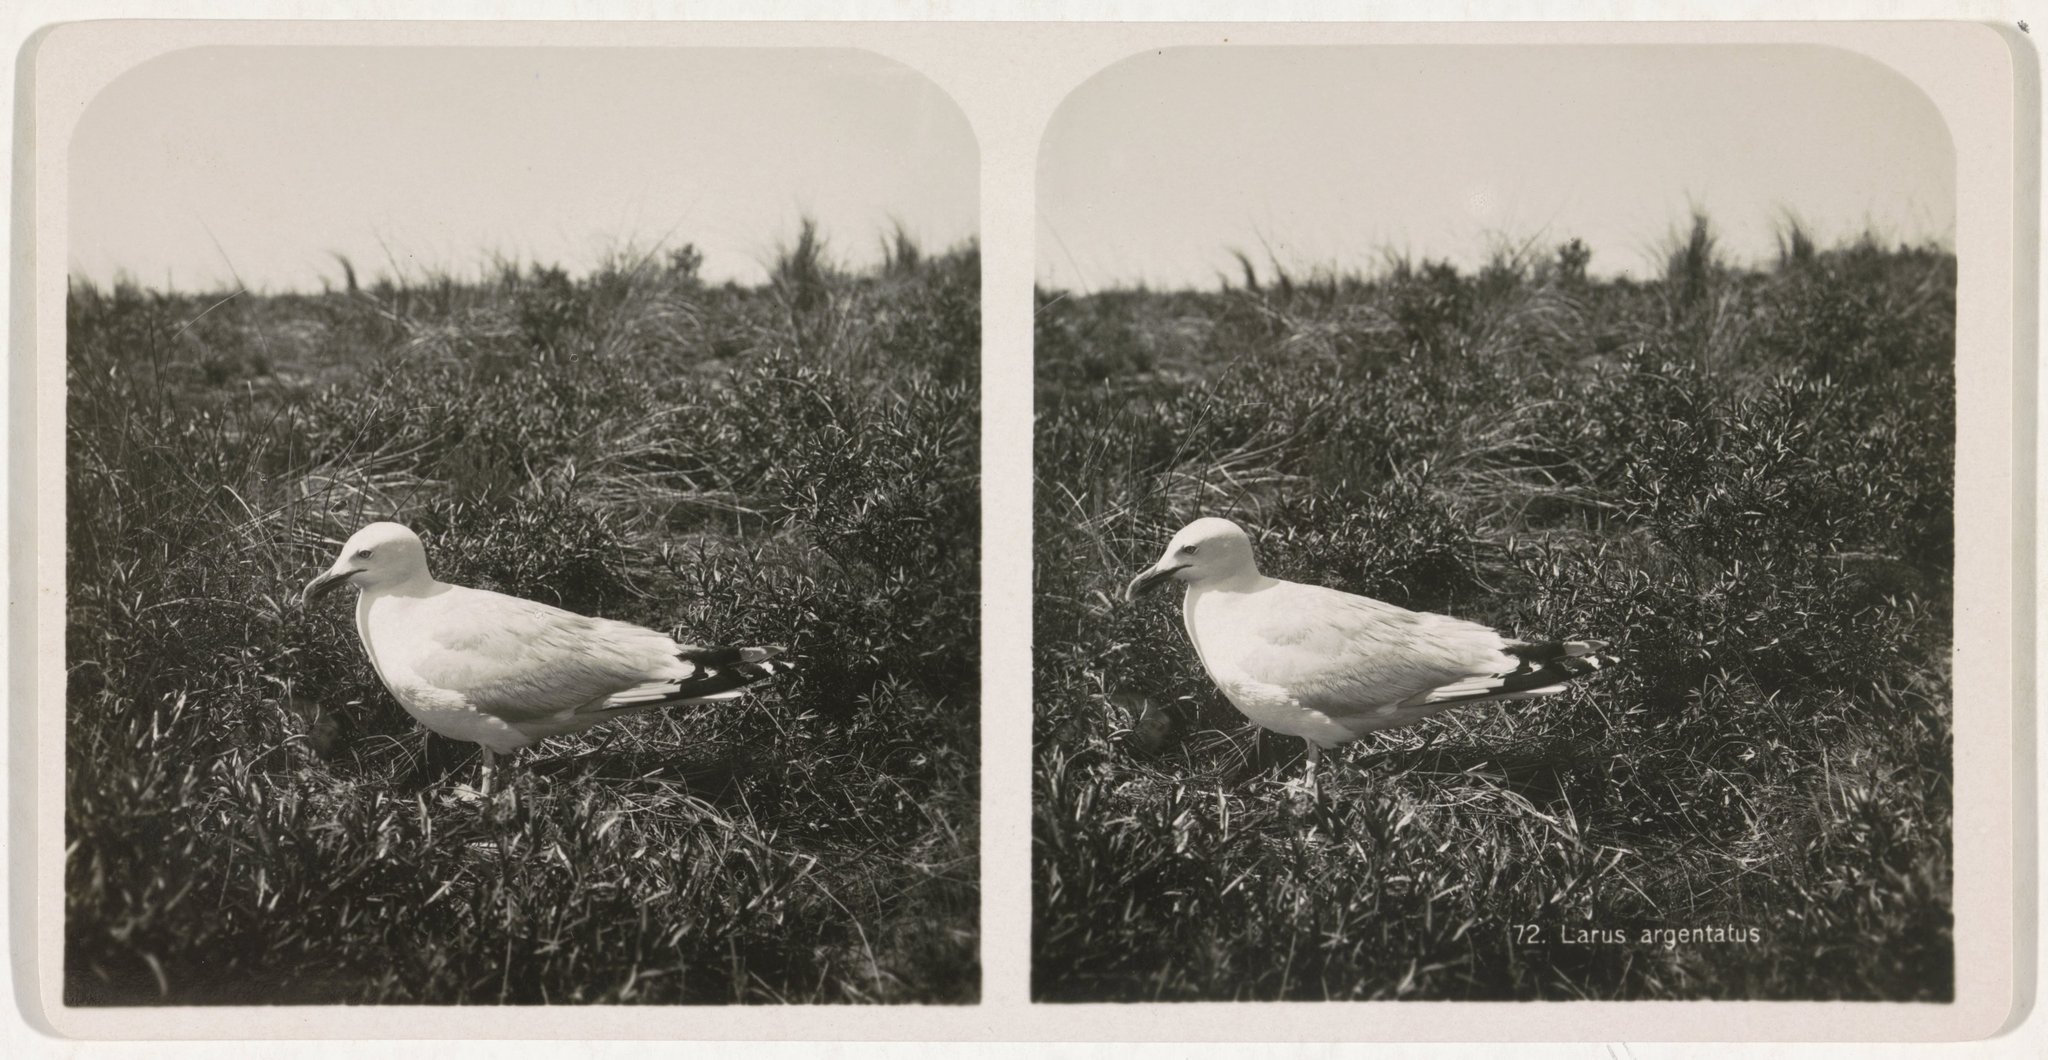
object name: photograph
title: Onze vogels in 't wild. / Zeevogels / Sterntjes en Meeuwen.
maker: adolphe burdet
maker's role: fotograaf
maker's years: 1860-1940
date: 1870-1940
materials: photographic support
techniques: gelatin silver print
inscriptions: label: ‘Meeuw’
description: De foto maakt deel uit van een serie van 12 stereofoto's, bewaard in het originele mapje. De foto's tonen zeevogels in natuurgebied De Bol op Texel.